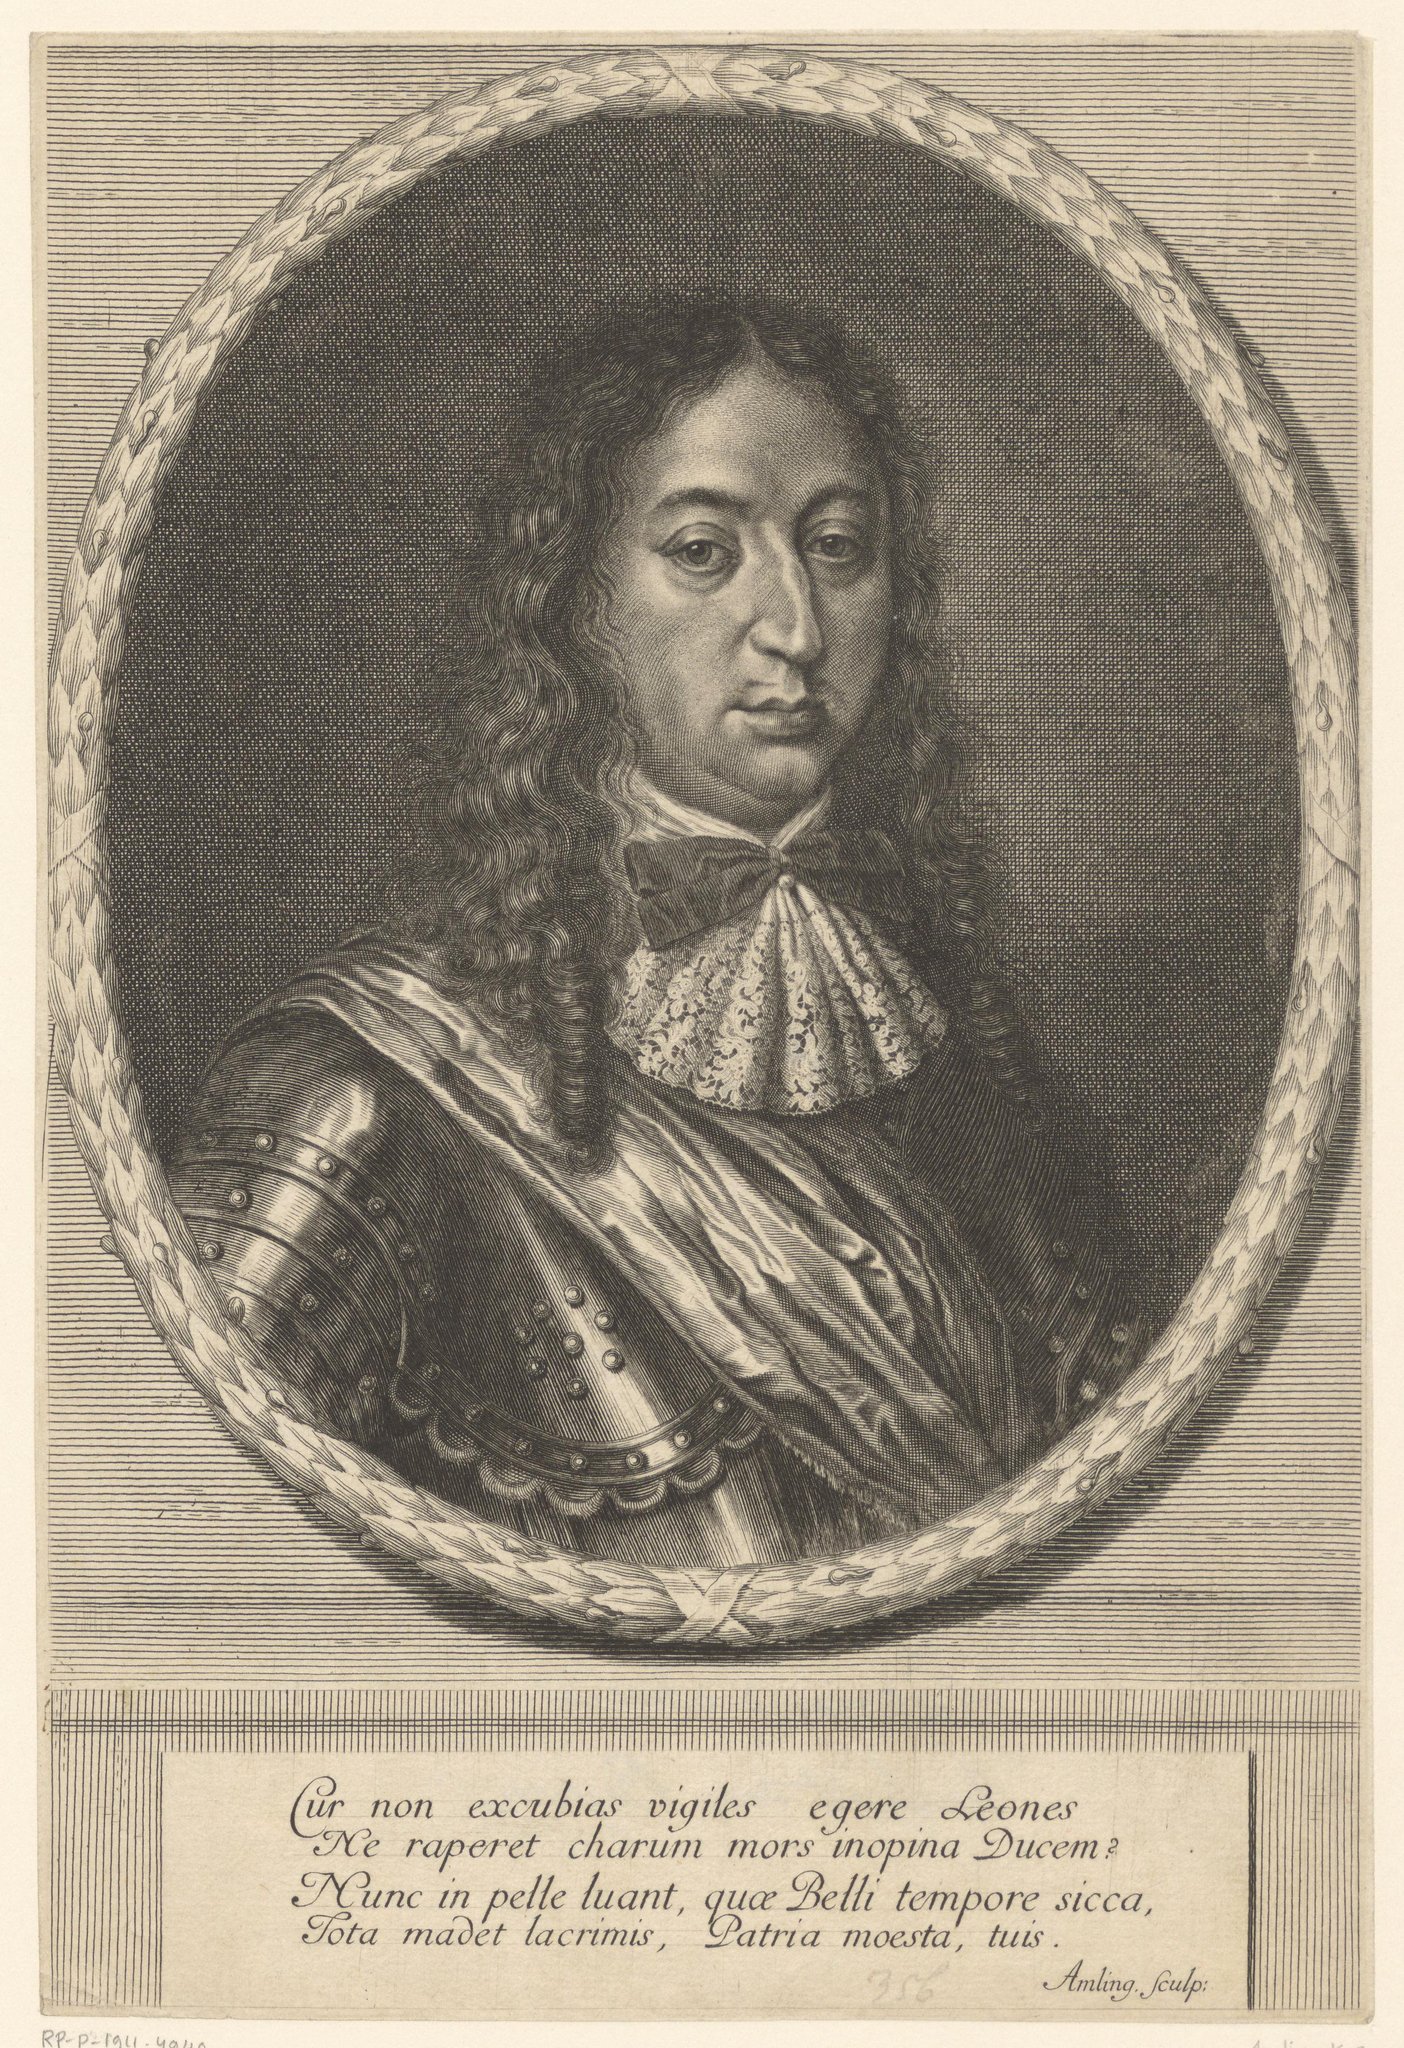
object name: print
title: Portret van Ferdinand Maria van Beieren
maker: karl gustav amling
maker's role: print maker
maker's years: 1651-1702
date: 1679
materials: paper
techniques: engraving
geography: munich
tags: ferdinand maria keurvorst van beieren, historical persons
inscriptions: collector's mark: Lugt 2228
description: Volgens Nagler is dit portret ook gebruikt als illustratie in: Funebri Jacobi Schmid, 1679.